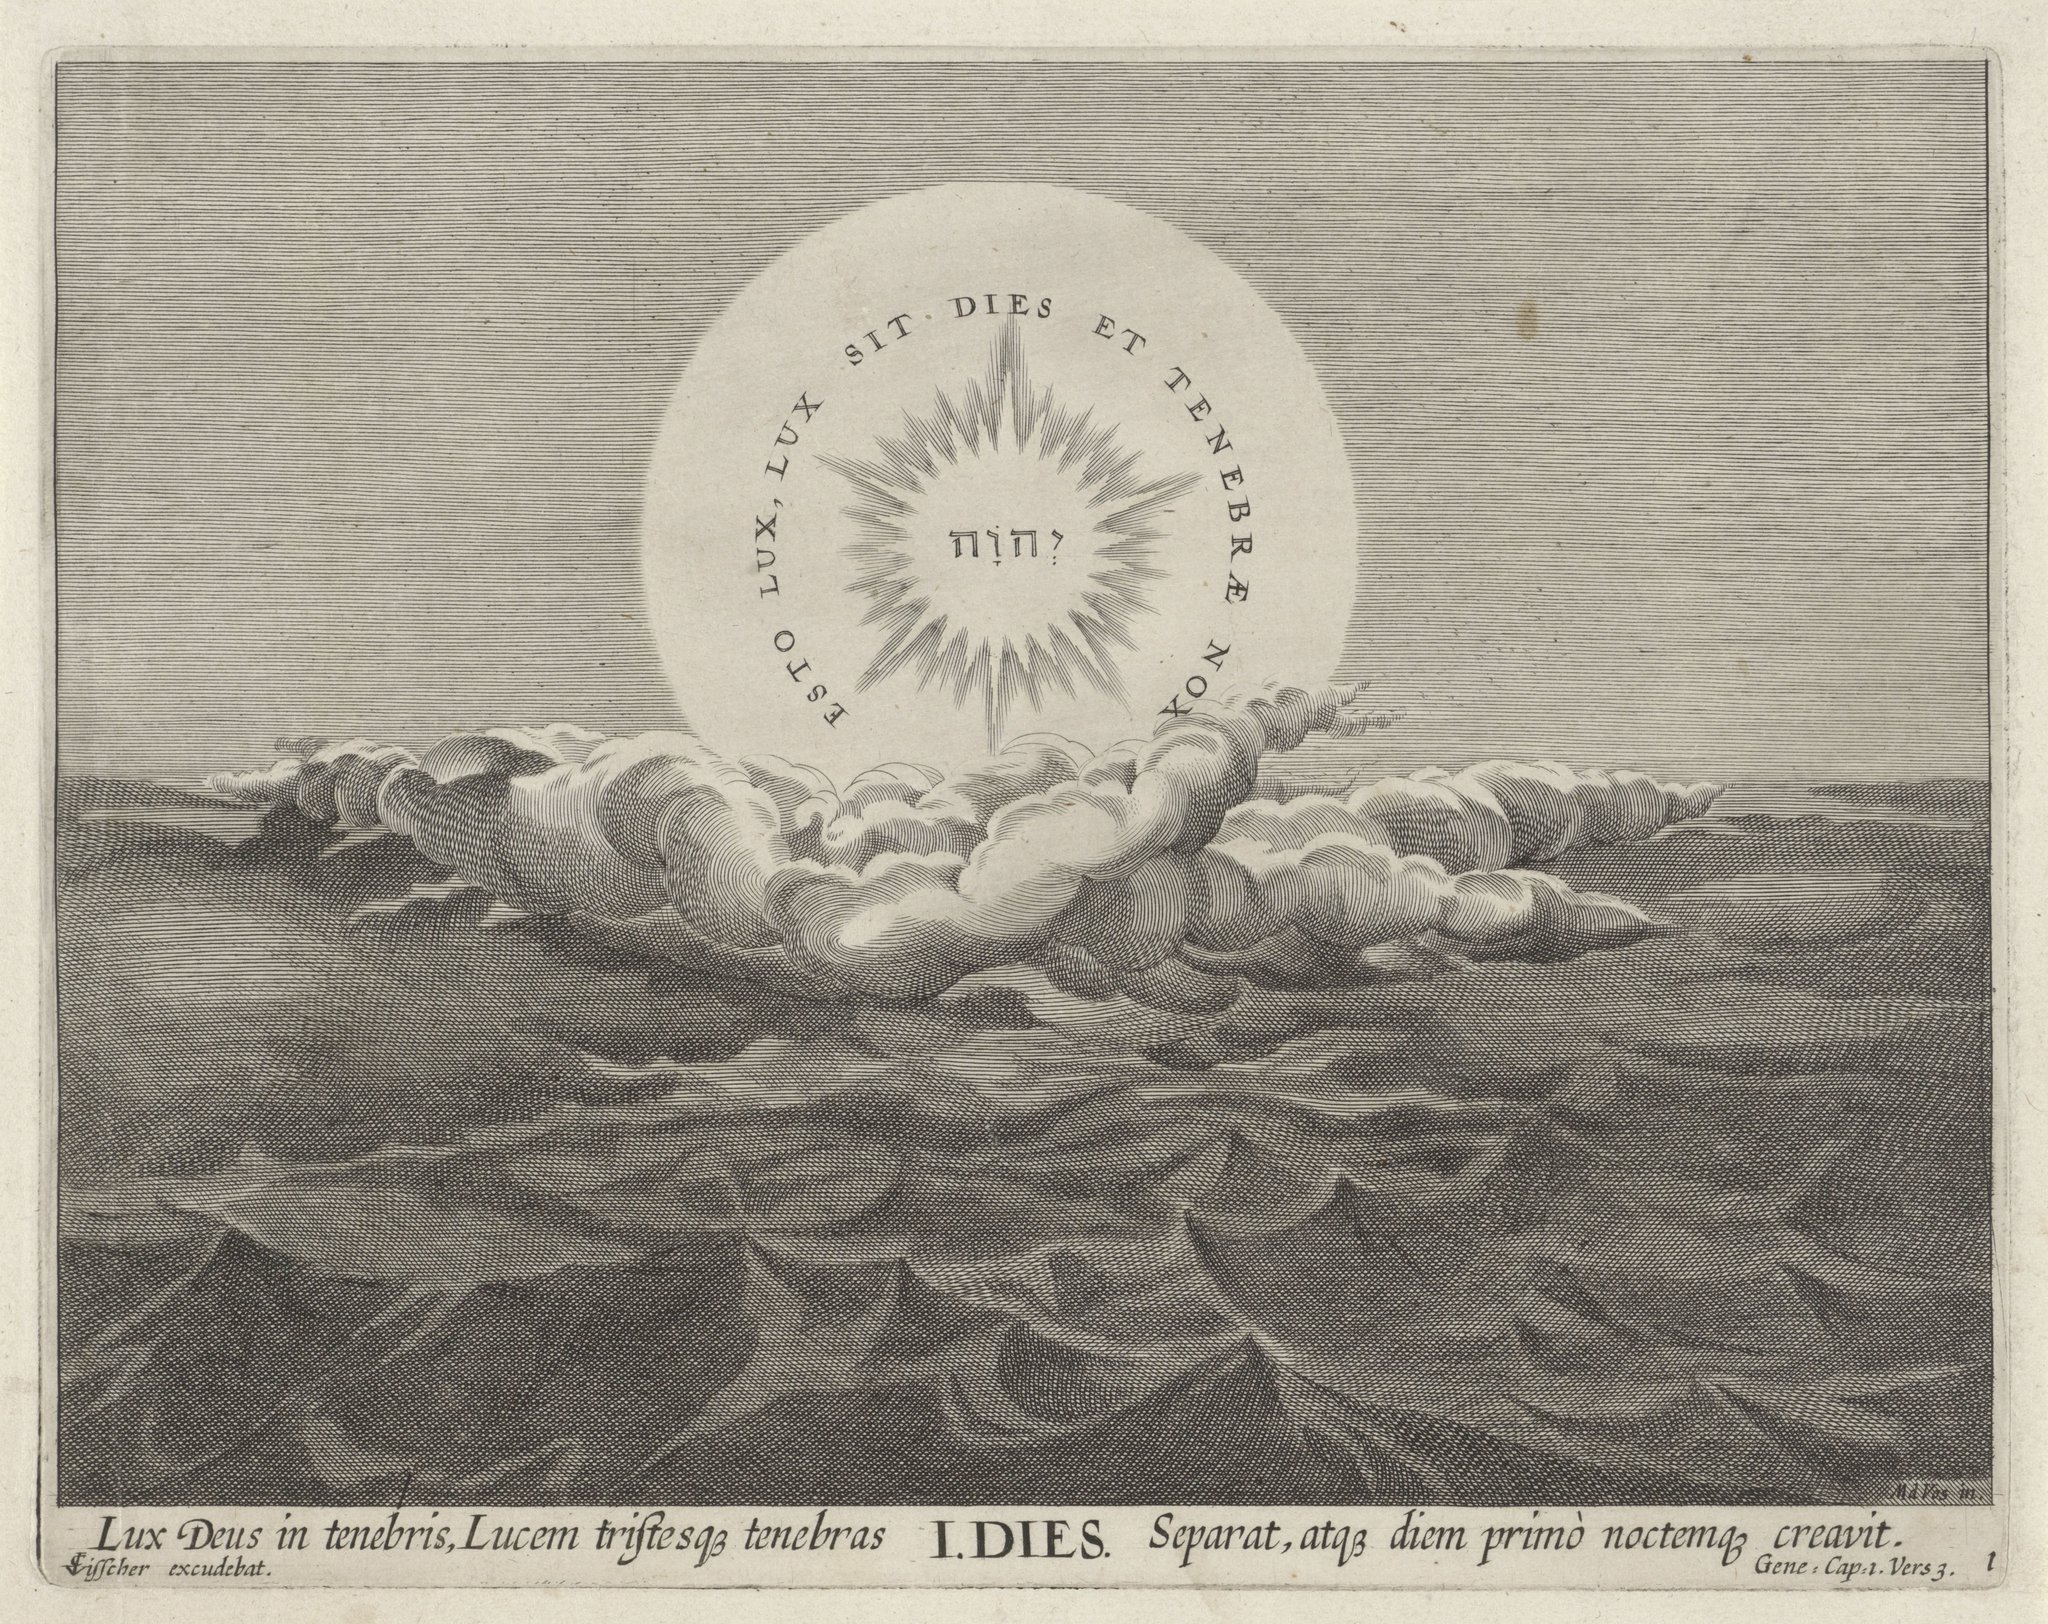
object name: print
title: Schepping van de wereld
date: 1588-1600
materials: paper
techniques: engraving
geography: amsterdam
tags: division of light and darkness, tetragram (in roman or hebrew script) ~ symbol of god the father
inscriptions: collector's mark: Lugt 2228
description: God in de vorm van een tetragram zweeft op een wolk: boven hem is er licht, onder hem duisternis. Op de eerste dag van de schepping schiep God licht en duisternis. De eerste prent van een achtdelige reeks over het scheppingsverhaal. De prent heeft een Latijns onderschrift.